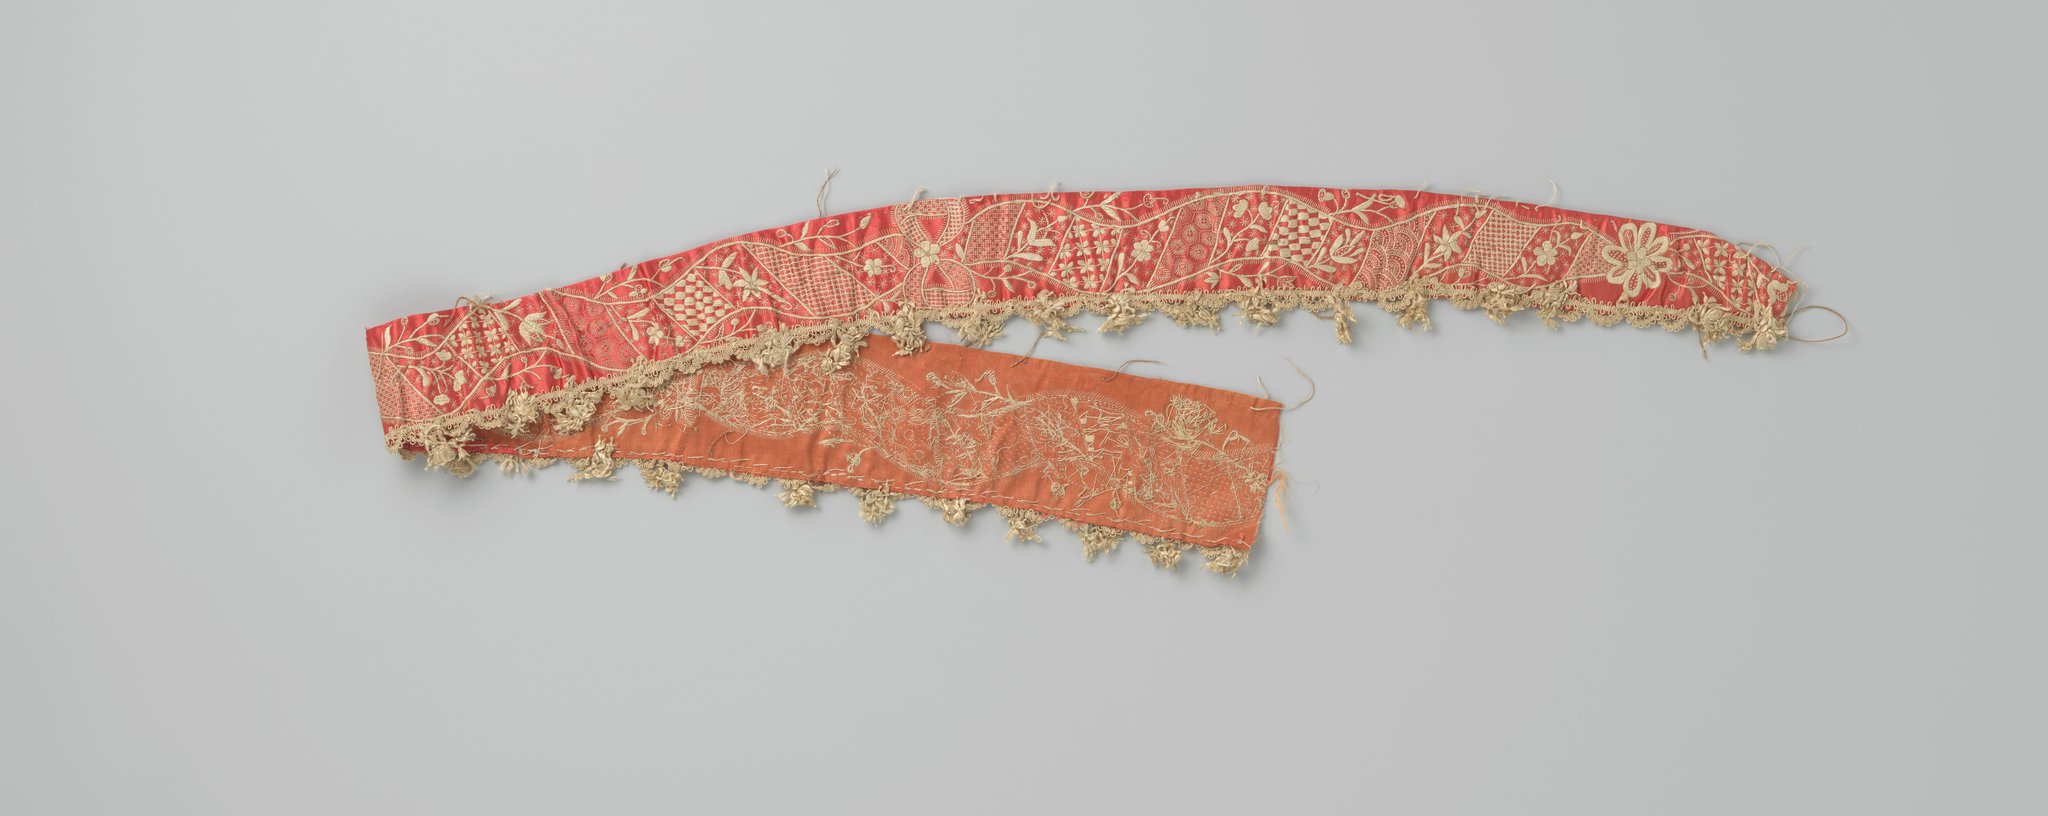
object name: strip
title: Embroidered Interior Textile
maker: Anonymous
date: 1750-1760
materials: silk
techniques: embroidered, weave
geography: france